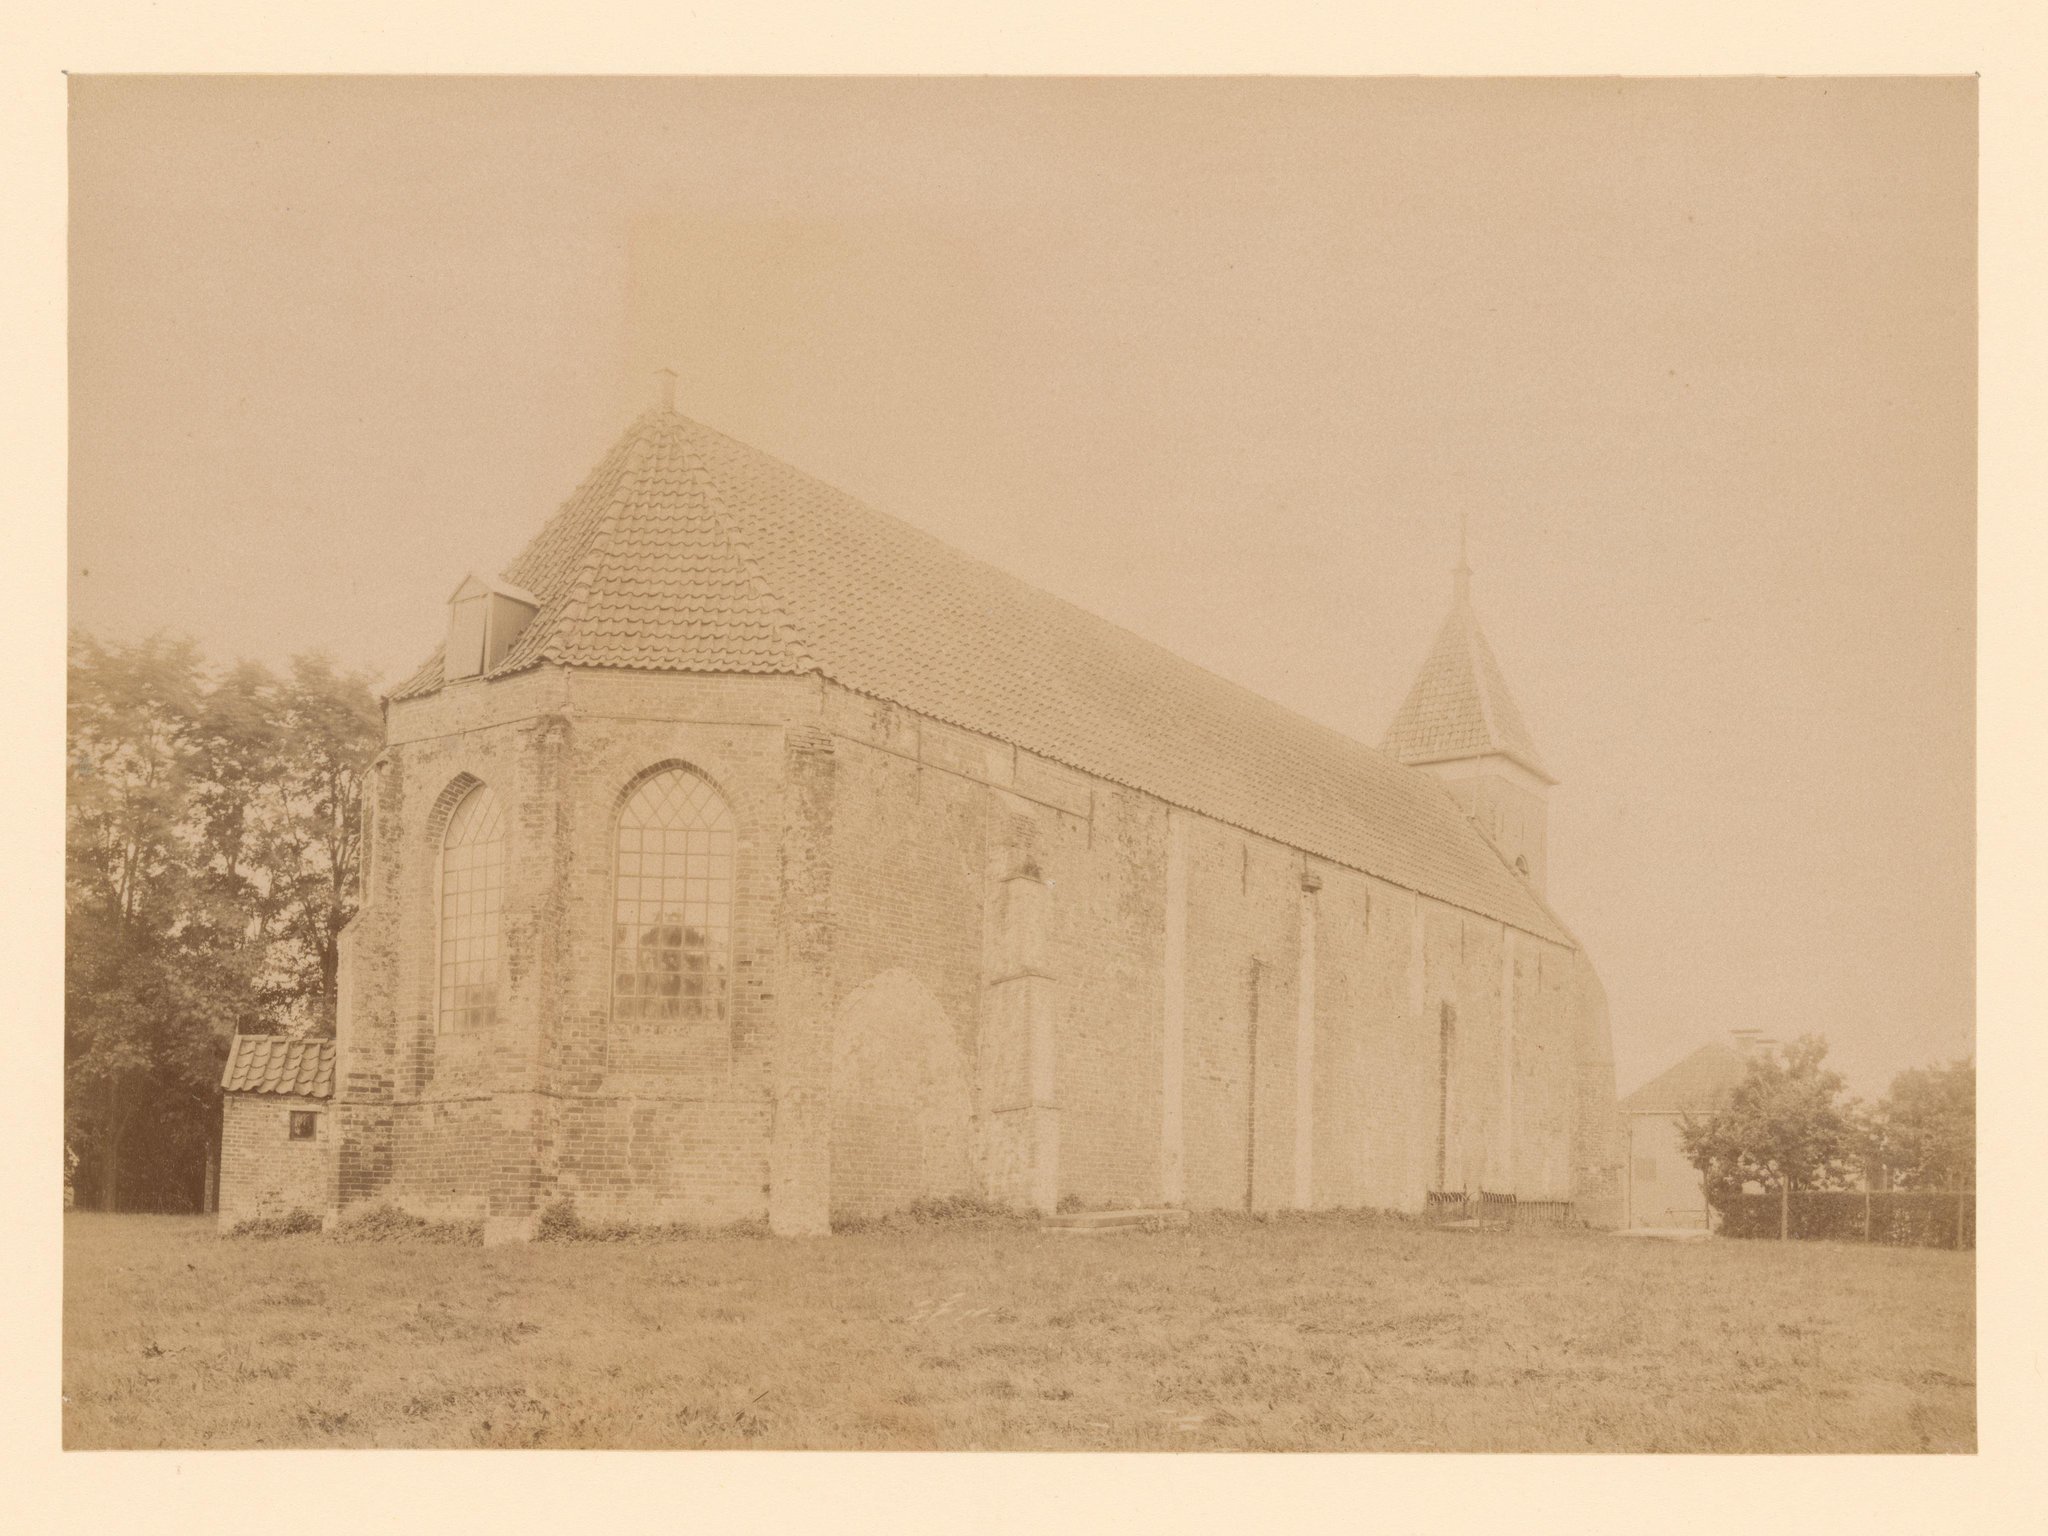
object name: photograph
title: Noordzijde van de Kerk van Vlagtwedde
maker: anoniem (monumentenzorg)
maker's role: fotograaf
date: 1893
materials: cardboard, photographic support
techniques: albumen print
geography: vlagtwedde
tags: church (exterior)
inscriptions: annotation: ‘Vlagtwedde/ noordzijde N.H. kerk/ sept 1893’, annotation: ‘Vlagtwedde’